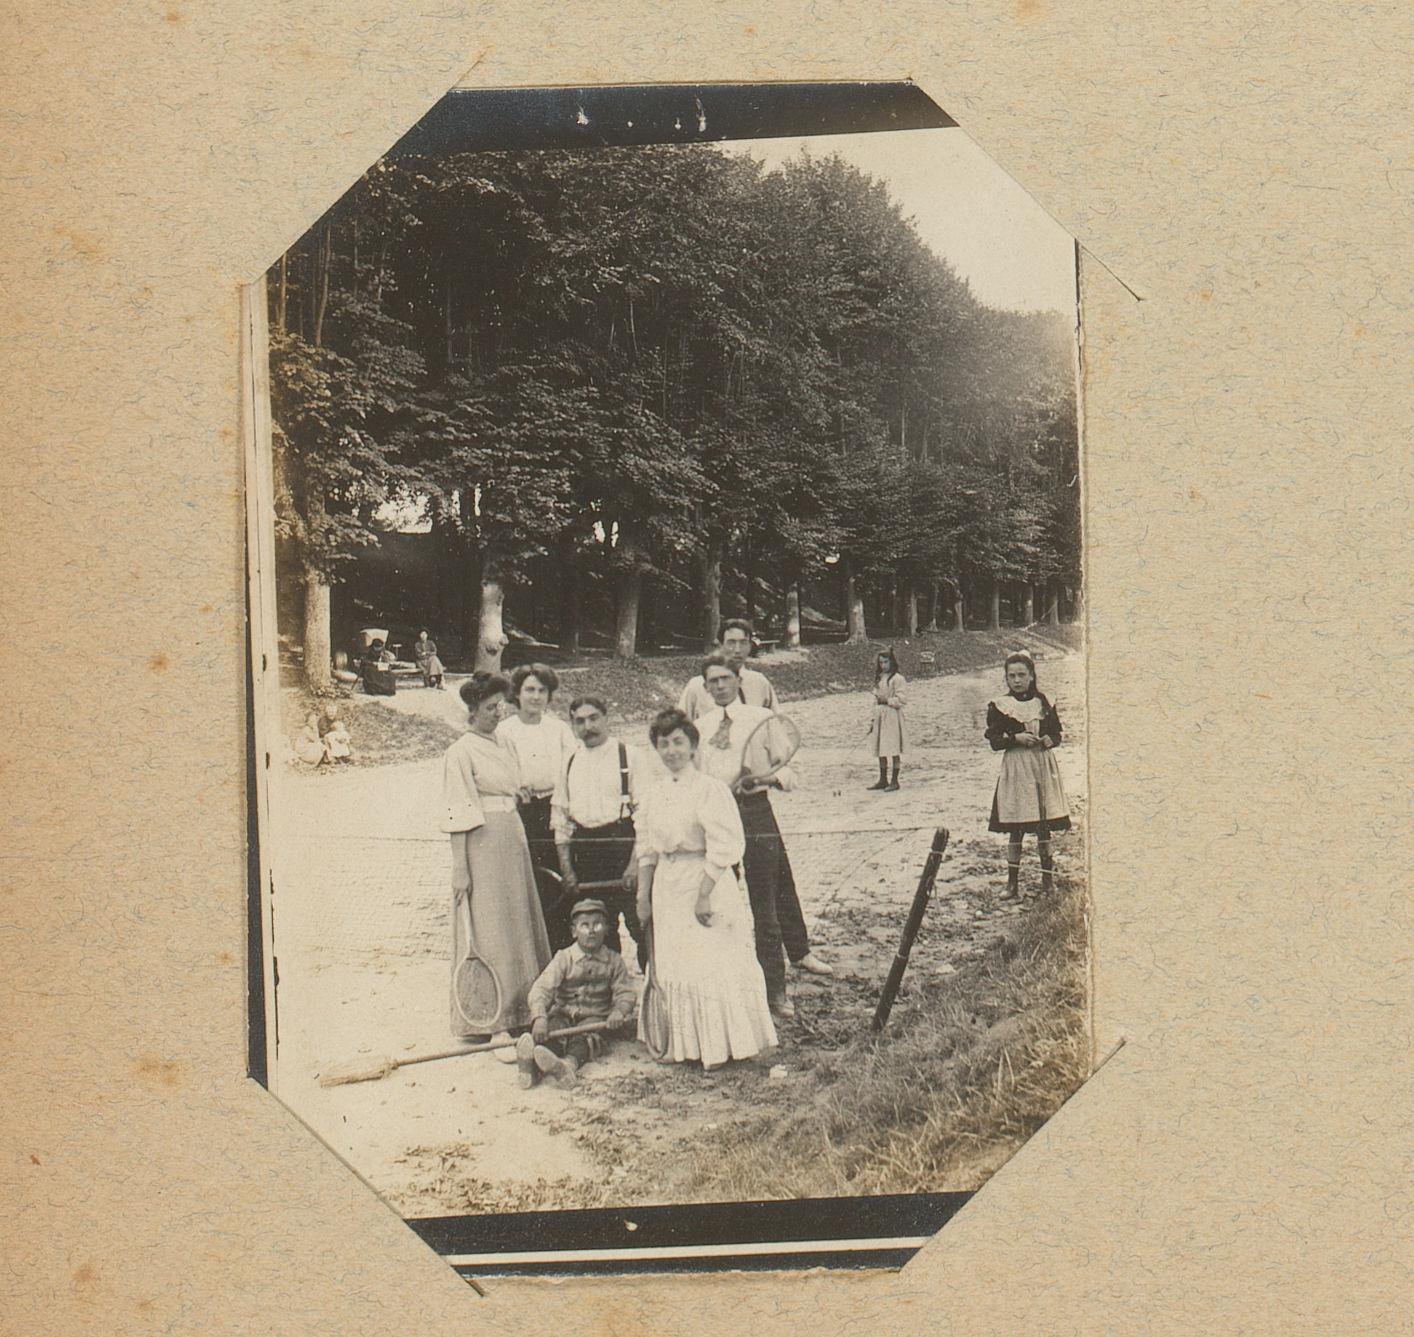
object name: album leaf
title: Groepsportret van een gezelschap met tennisrackets op een tennisbaan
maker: Anonymous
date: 1897-1900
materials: paper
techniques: gelatin silver print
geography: france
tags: tennis, lawn-tennis, anonymous historical person portrayed, france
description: Over de foto is een ander negatief afgedrukt van een voorstelling van bomen.